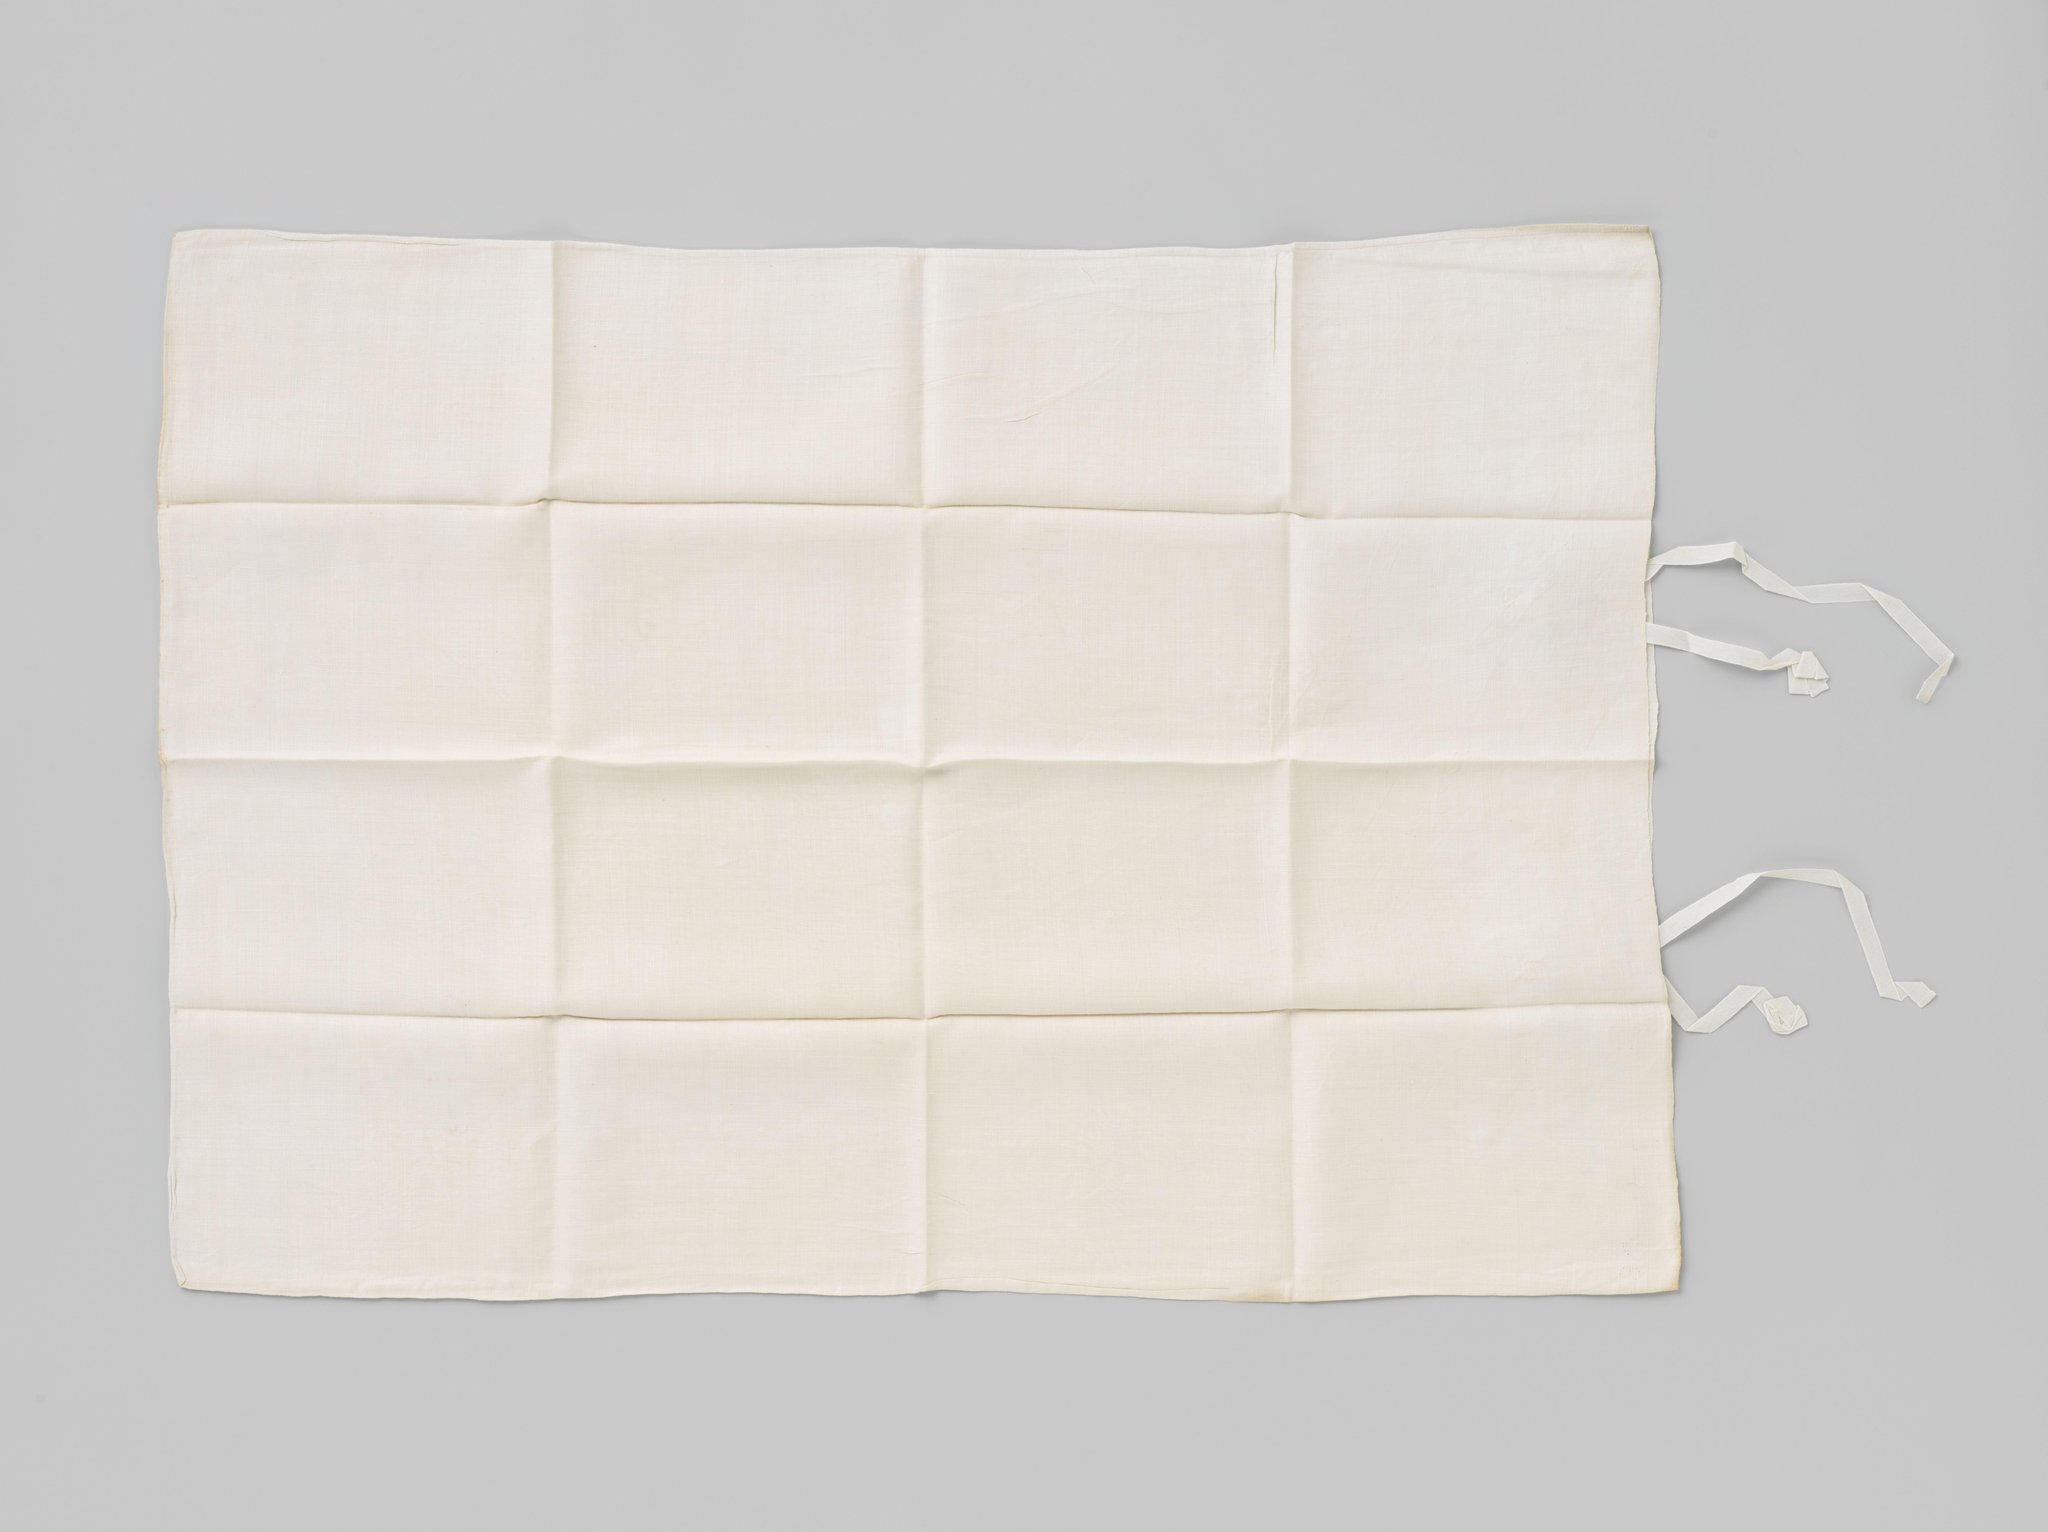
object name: sloop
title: Sloop van linnen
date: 1734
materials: linen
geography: northern netherlands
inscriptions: date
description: Sloop van linnen, merk WG22 en 1734 en HW13.